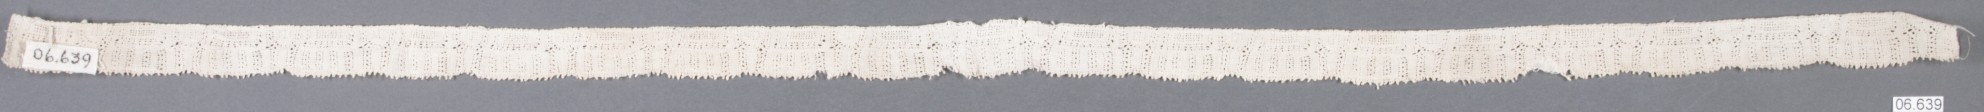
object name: fragment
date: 1601-1700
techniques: lace